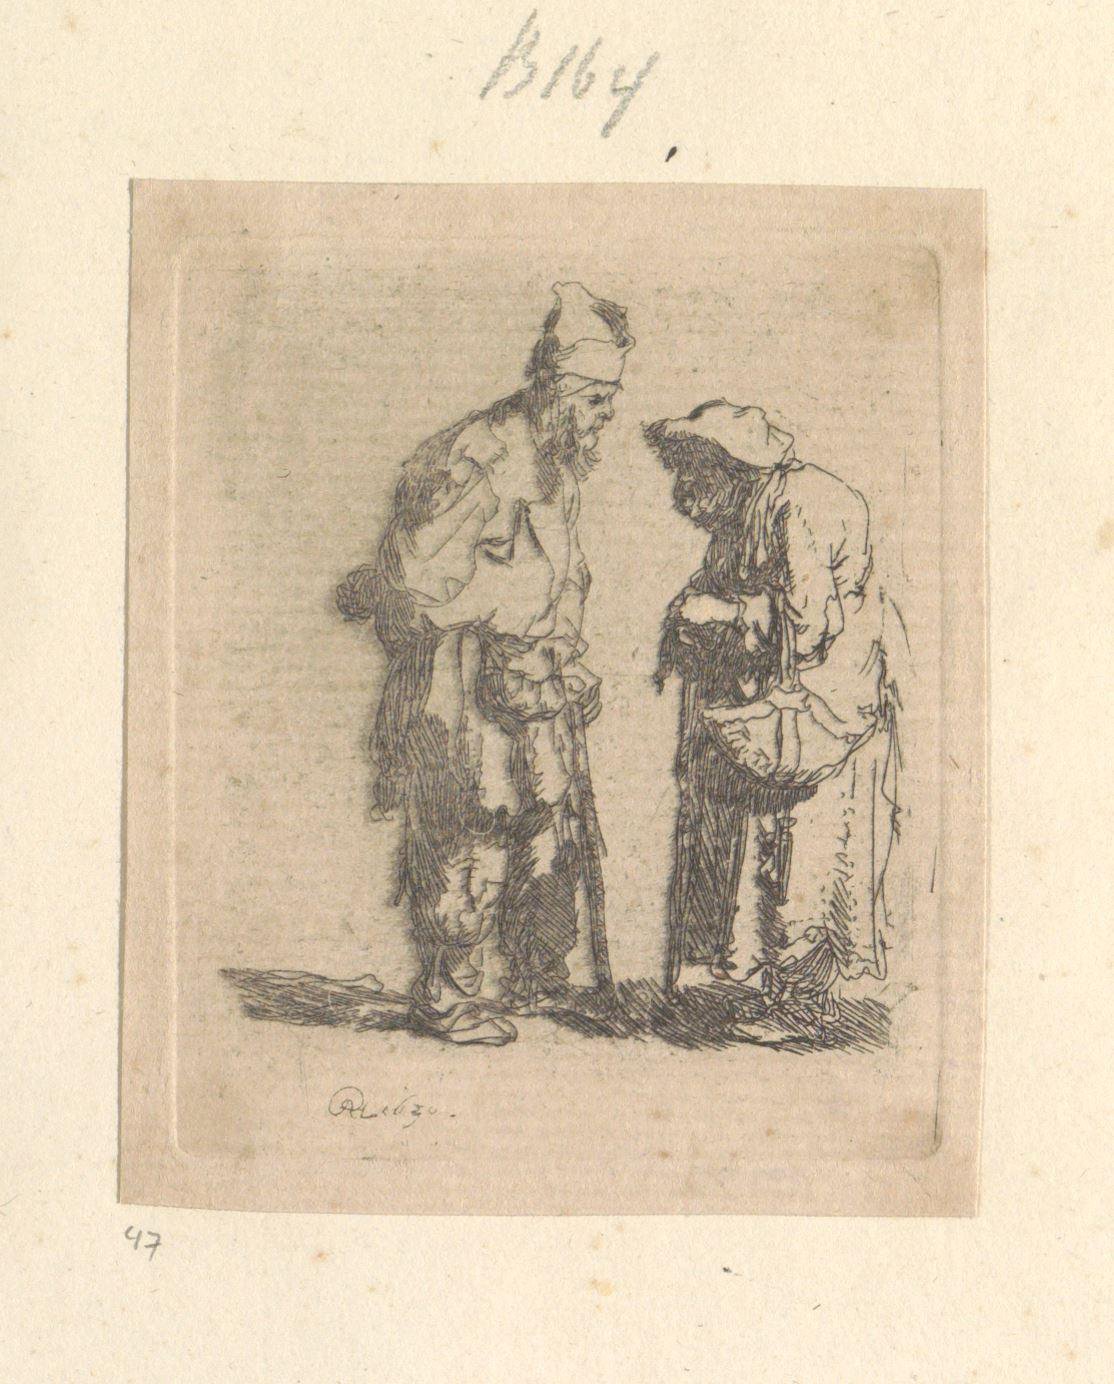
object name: print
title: Bedelaar en bedelares in gesprek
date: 1630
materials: paper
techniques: etching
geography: paris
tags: beggar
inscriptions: date